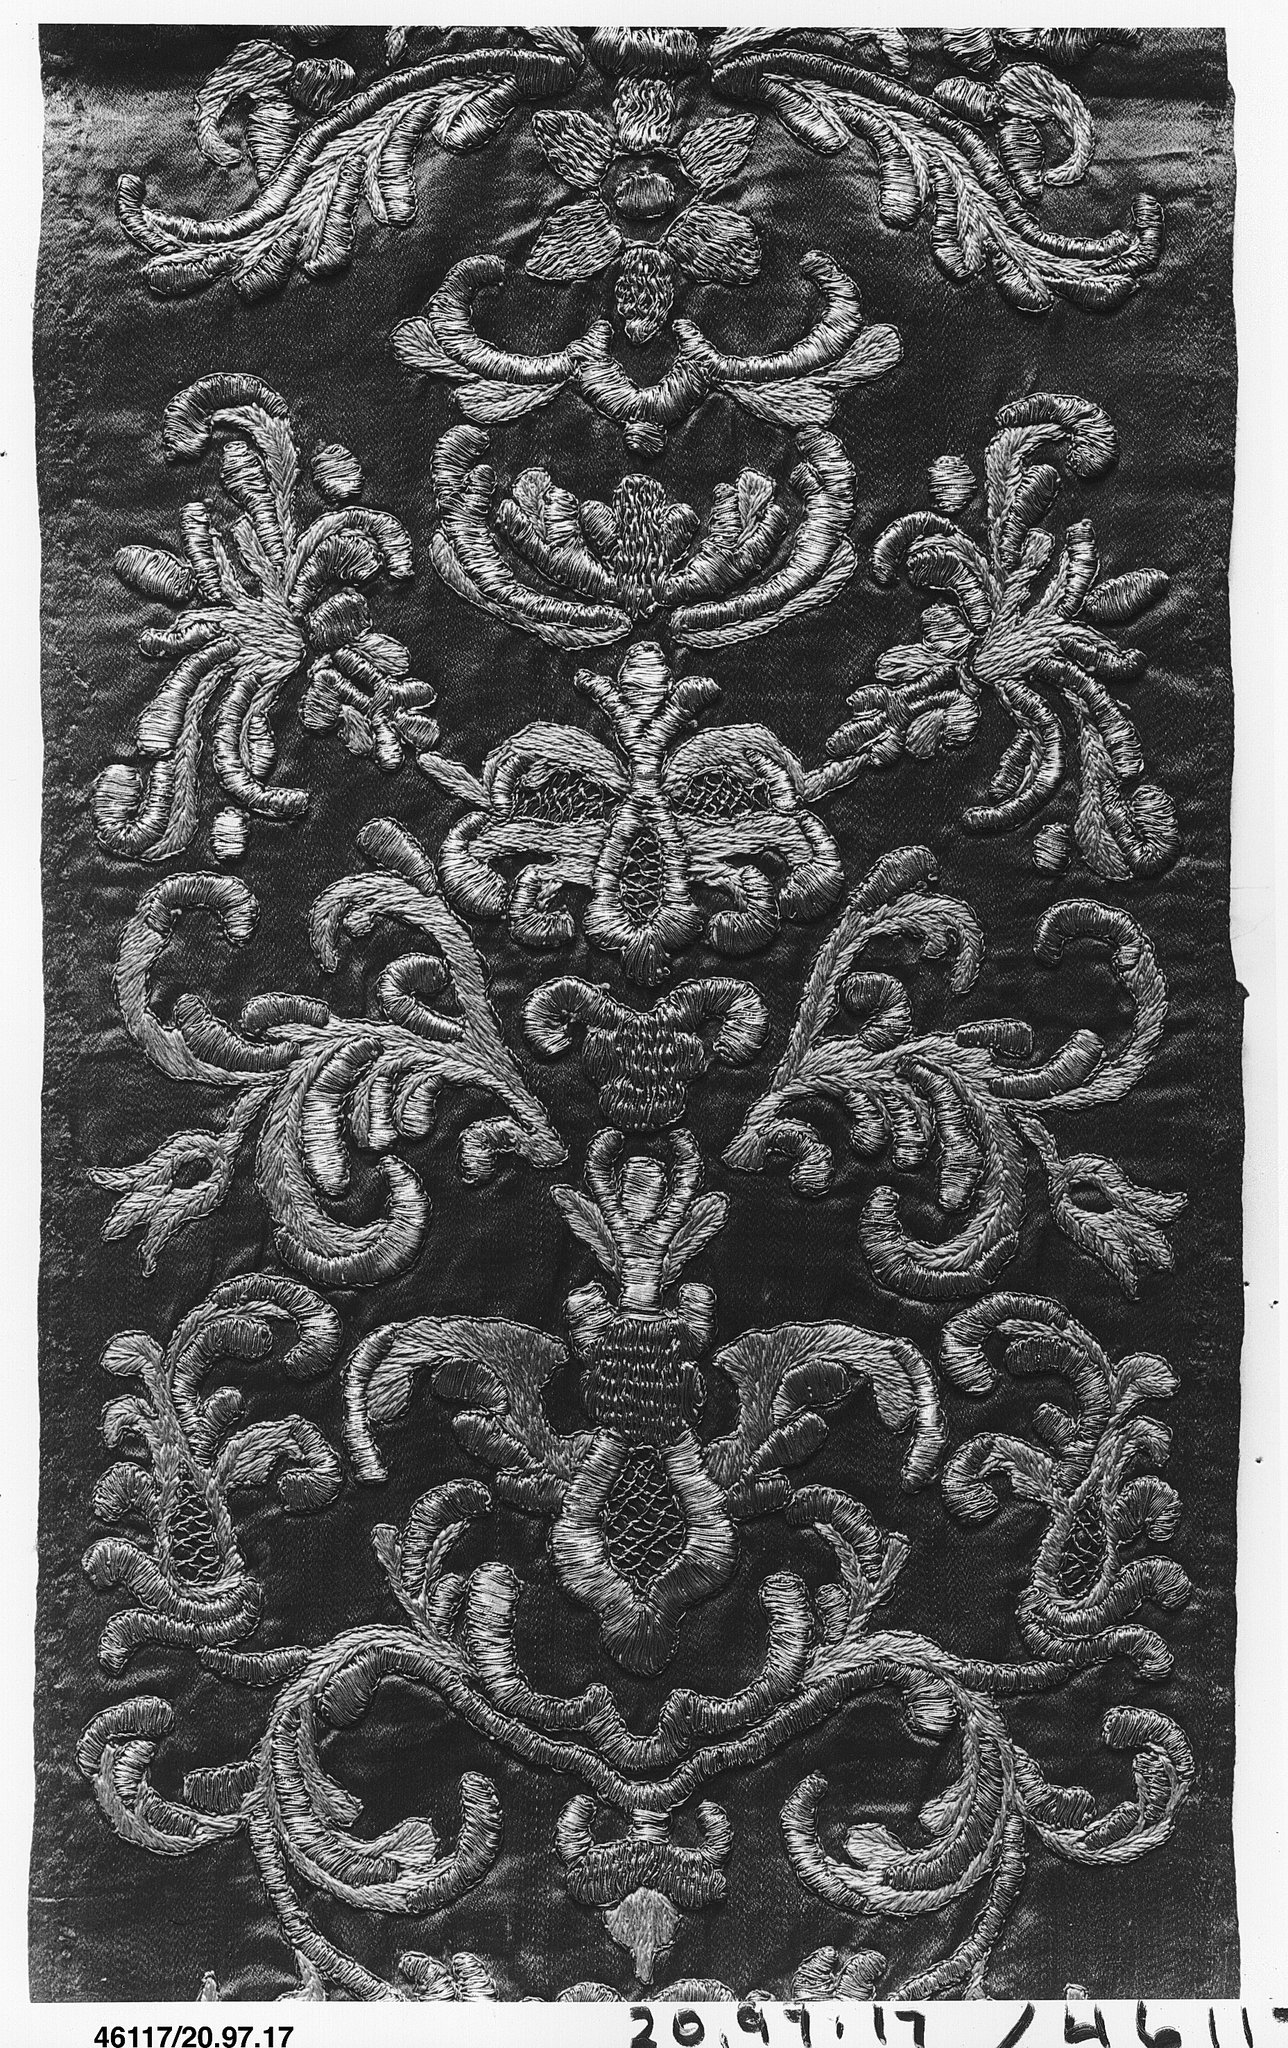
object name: fragment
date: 1601-1700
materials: metal thread, silk